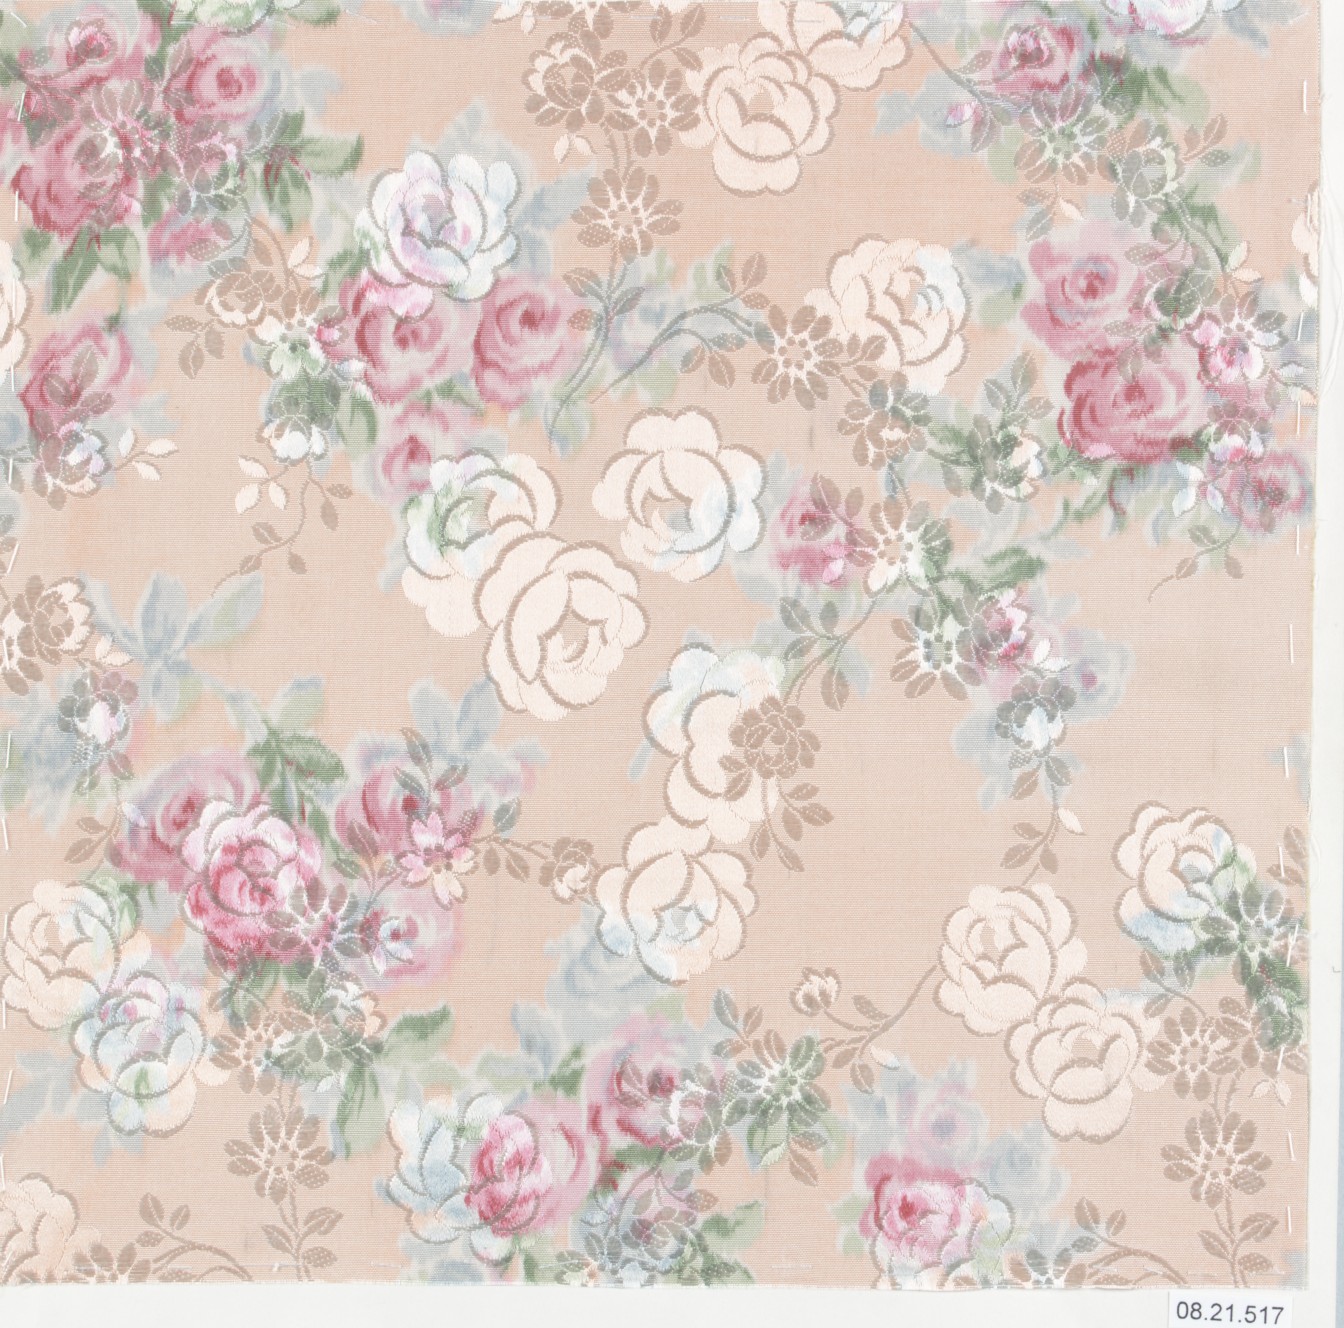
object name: textile sample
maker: Anonymous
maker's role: designer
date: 1900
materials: silk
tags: roses